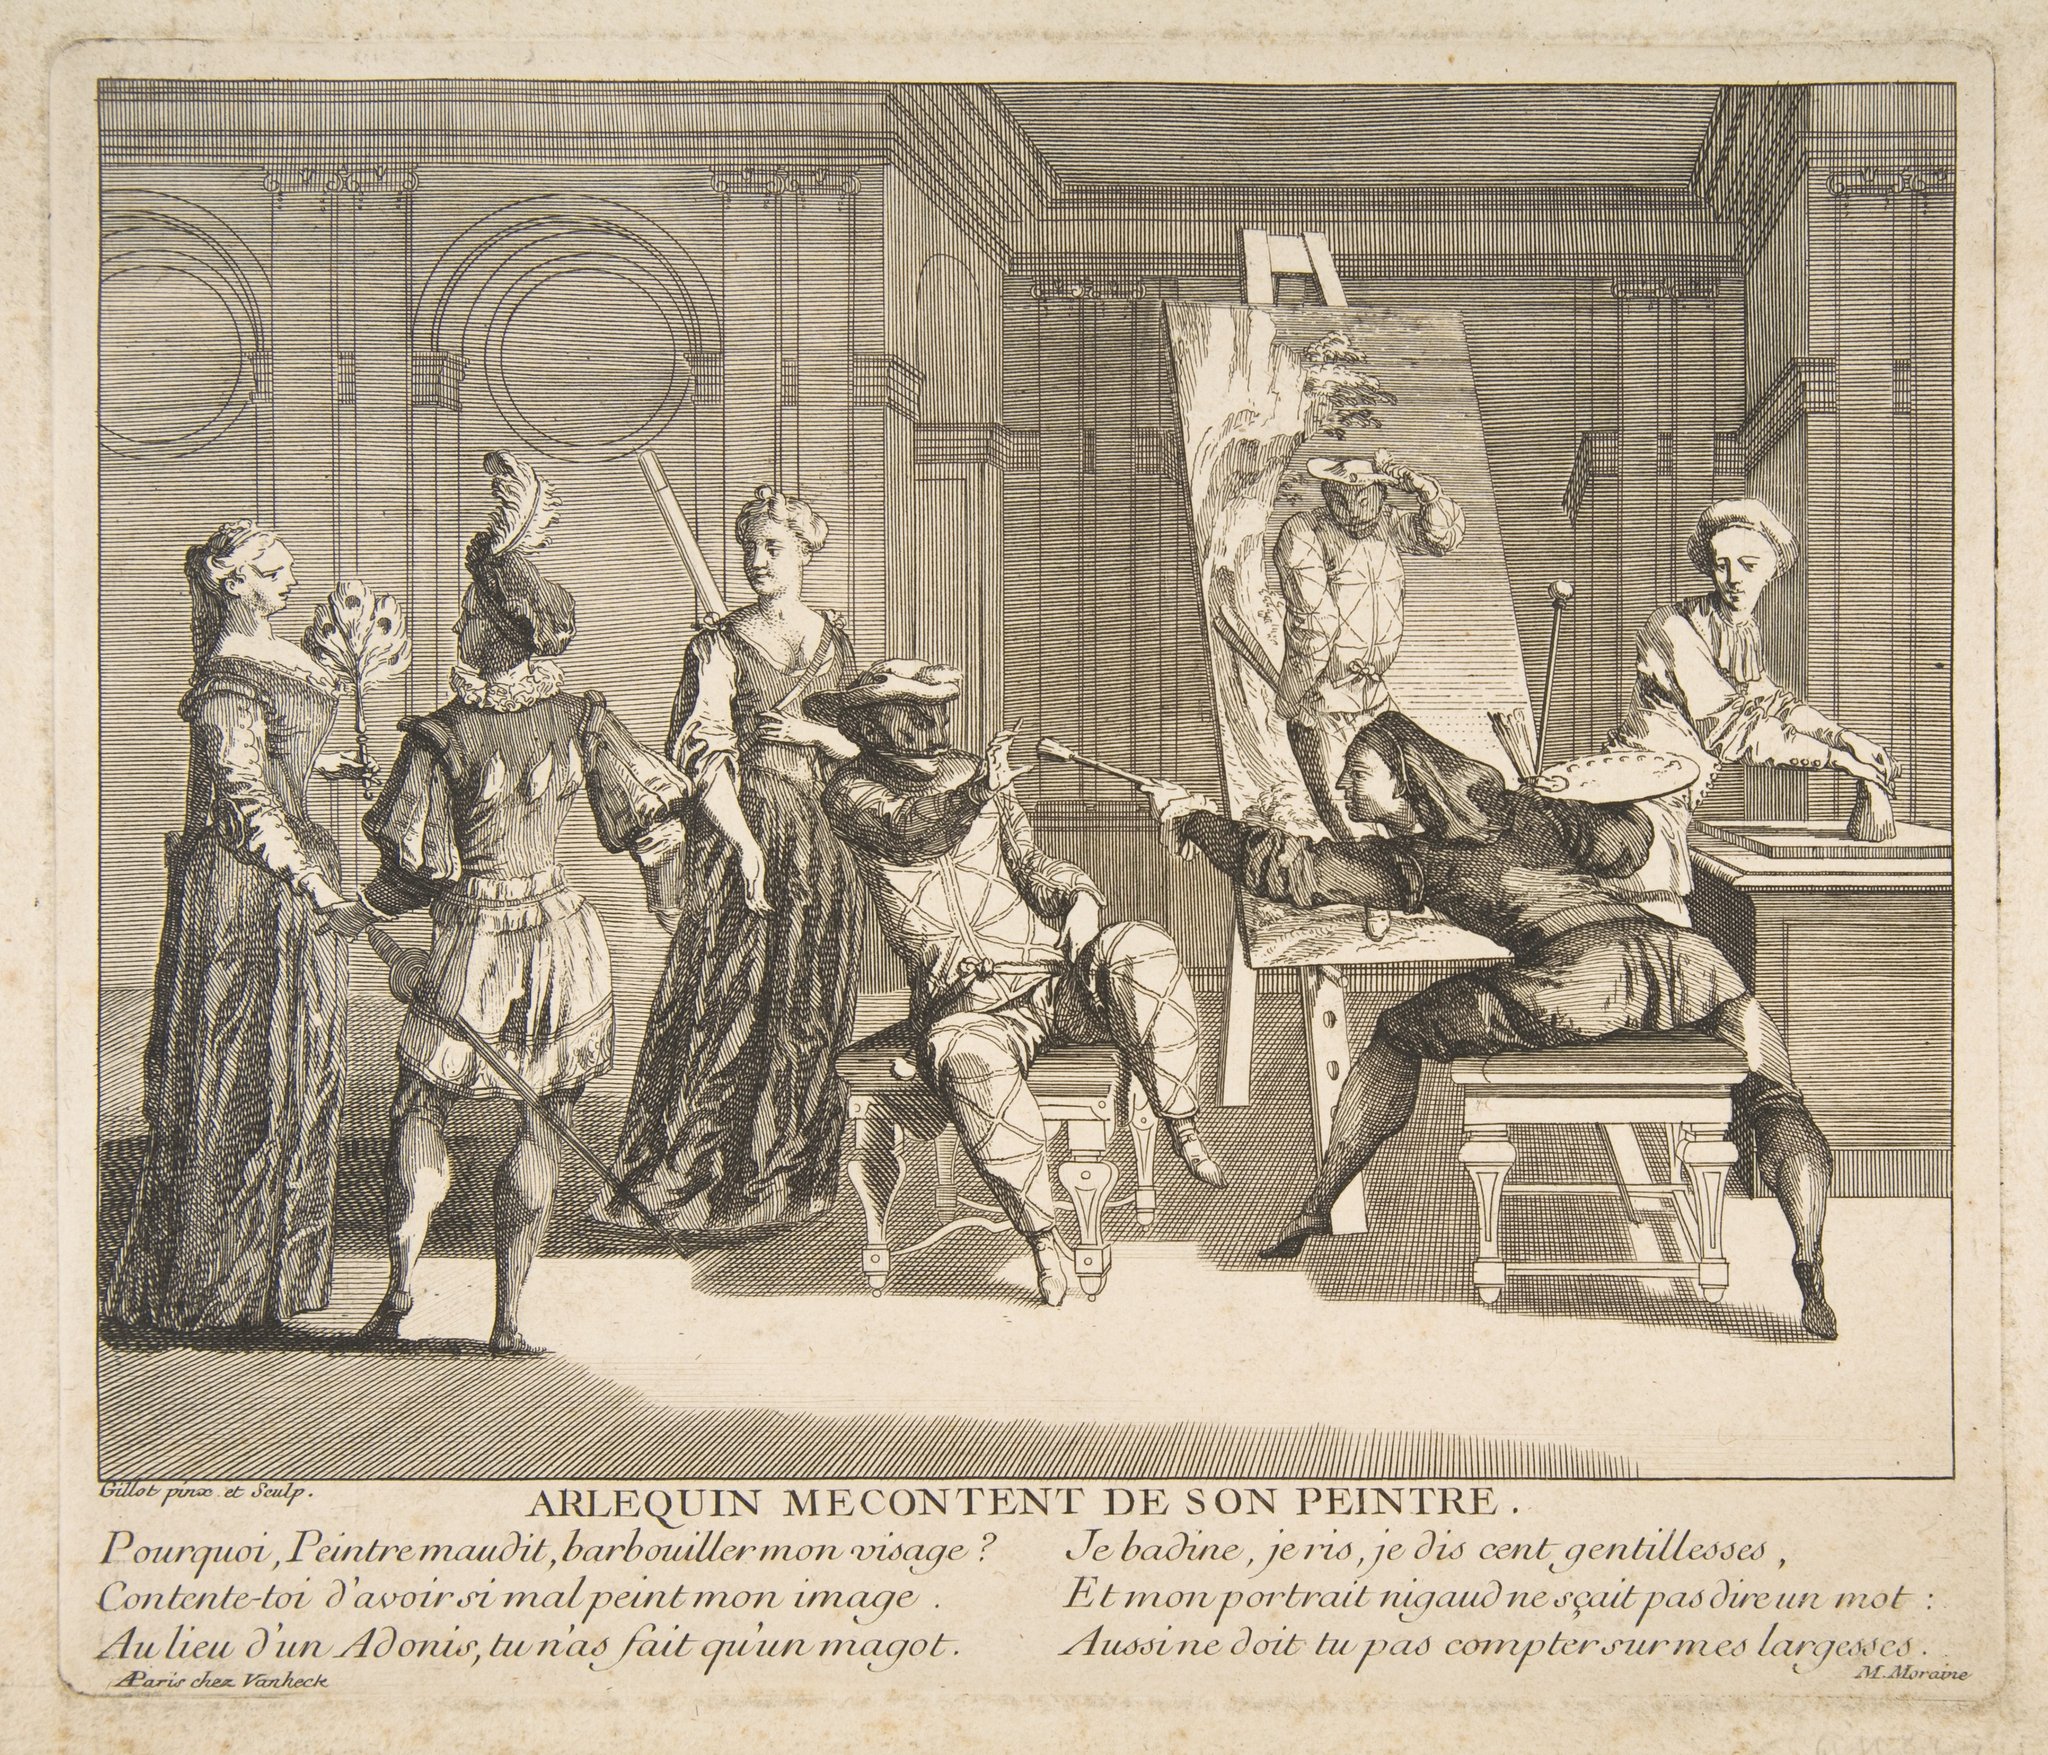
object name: print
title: Arlequin Mecontent de Son Peintre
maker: claude gillot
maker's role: artist and engraver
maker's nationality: french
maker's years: 1673-1722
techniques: etching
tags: painting,men,women